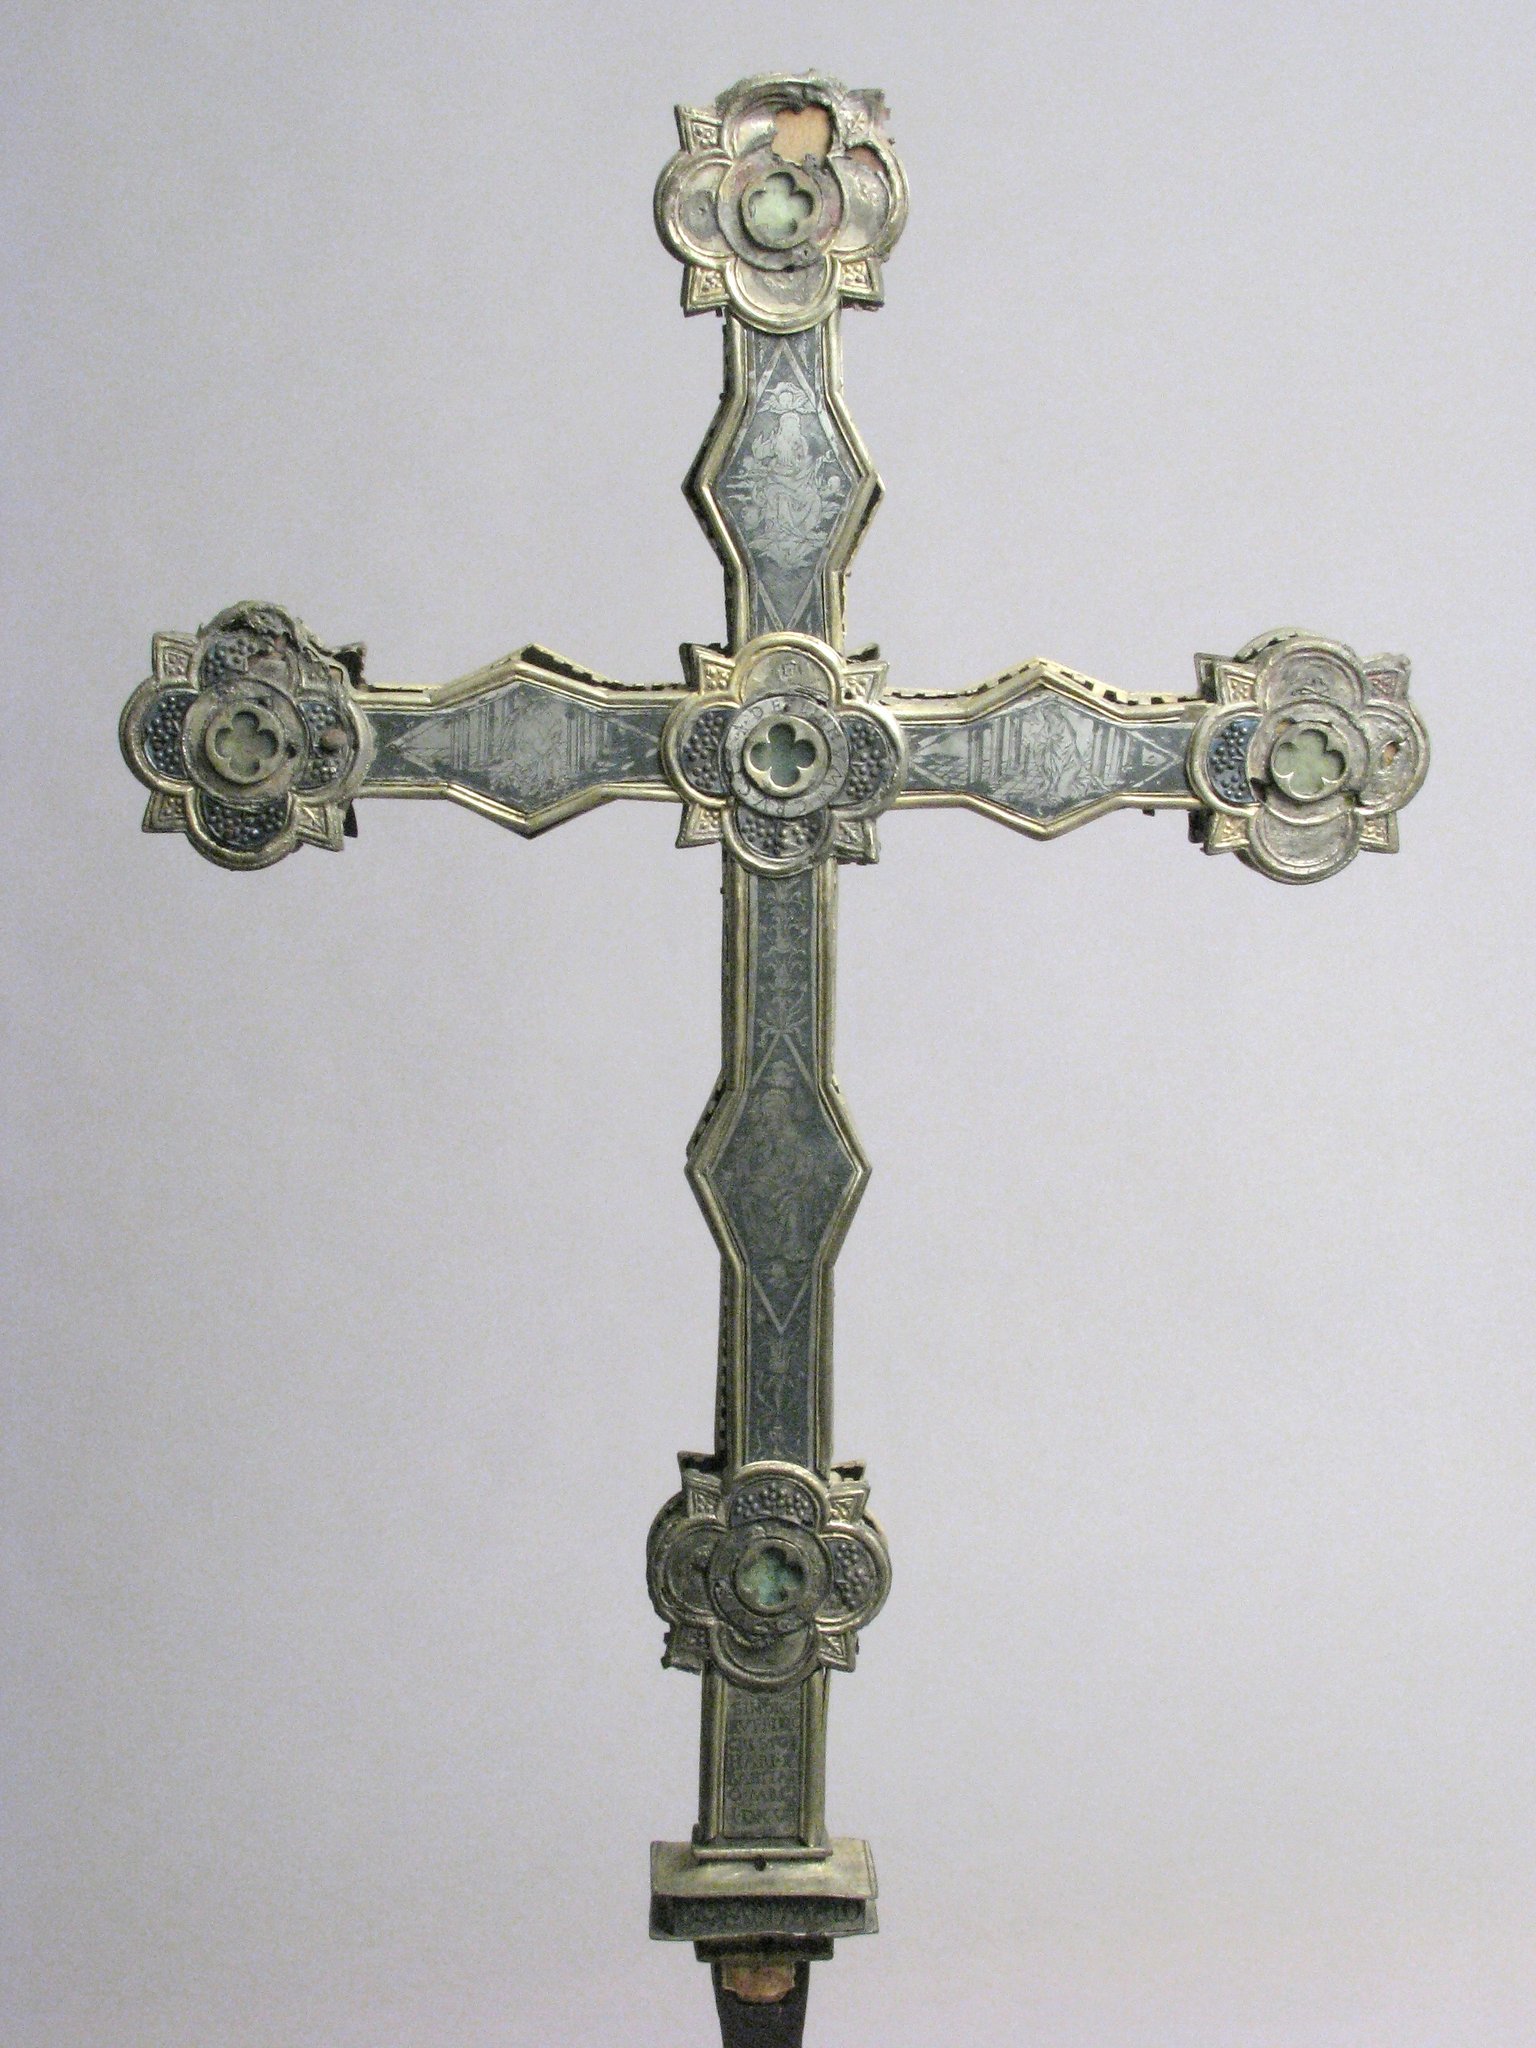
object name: reliquary cross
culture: italian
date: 1501-1600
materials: glass, niello, silver, silver gilt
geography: italy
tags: reliquaries